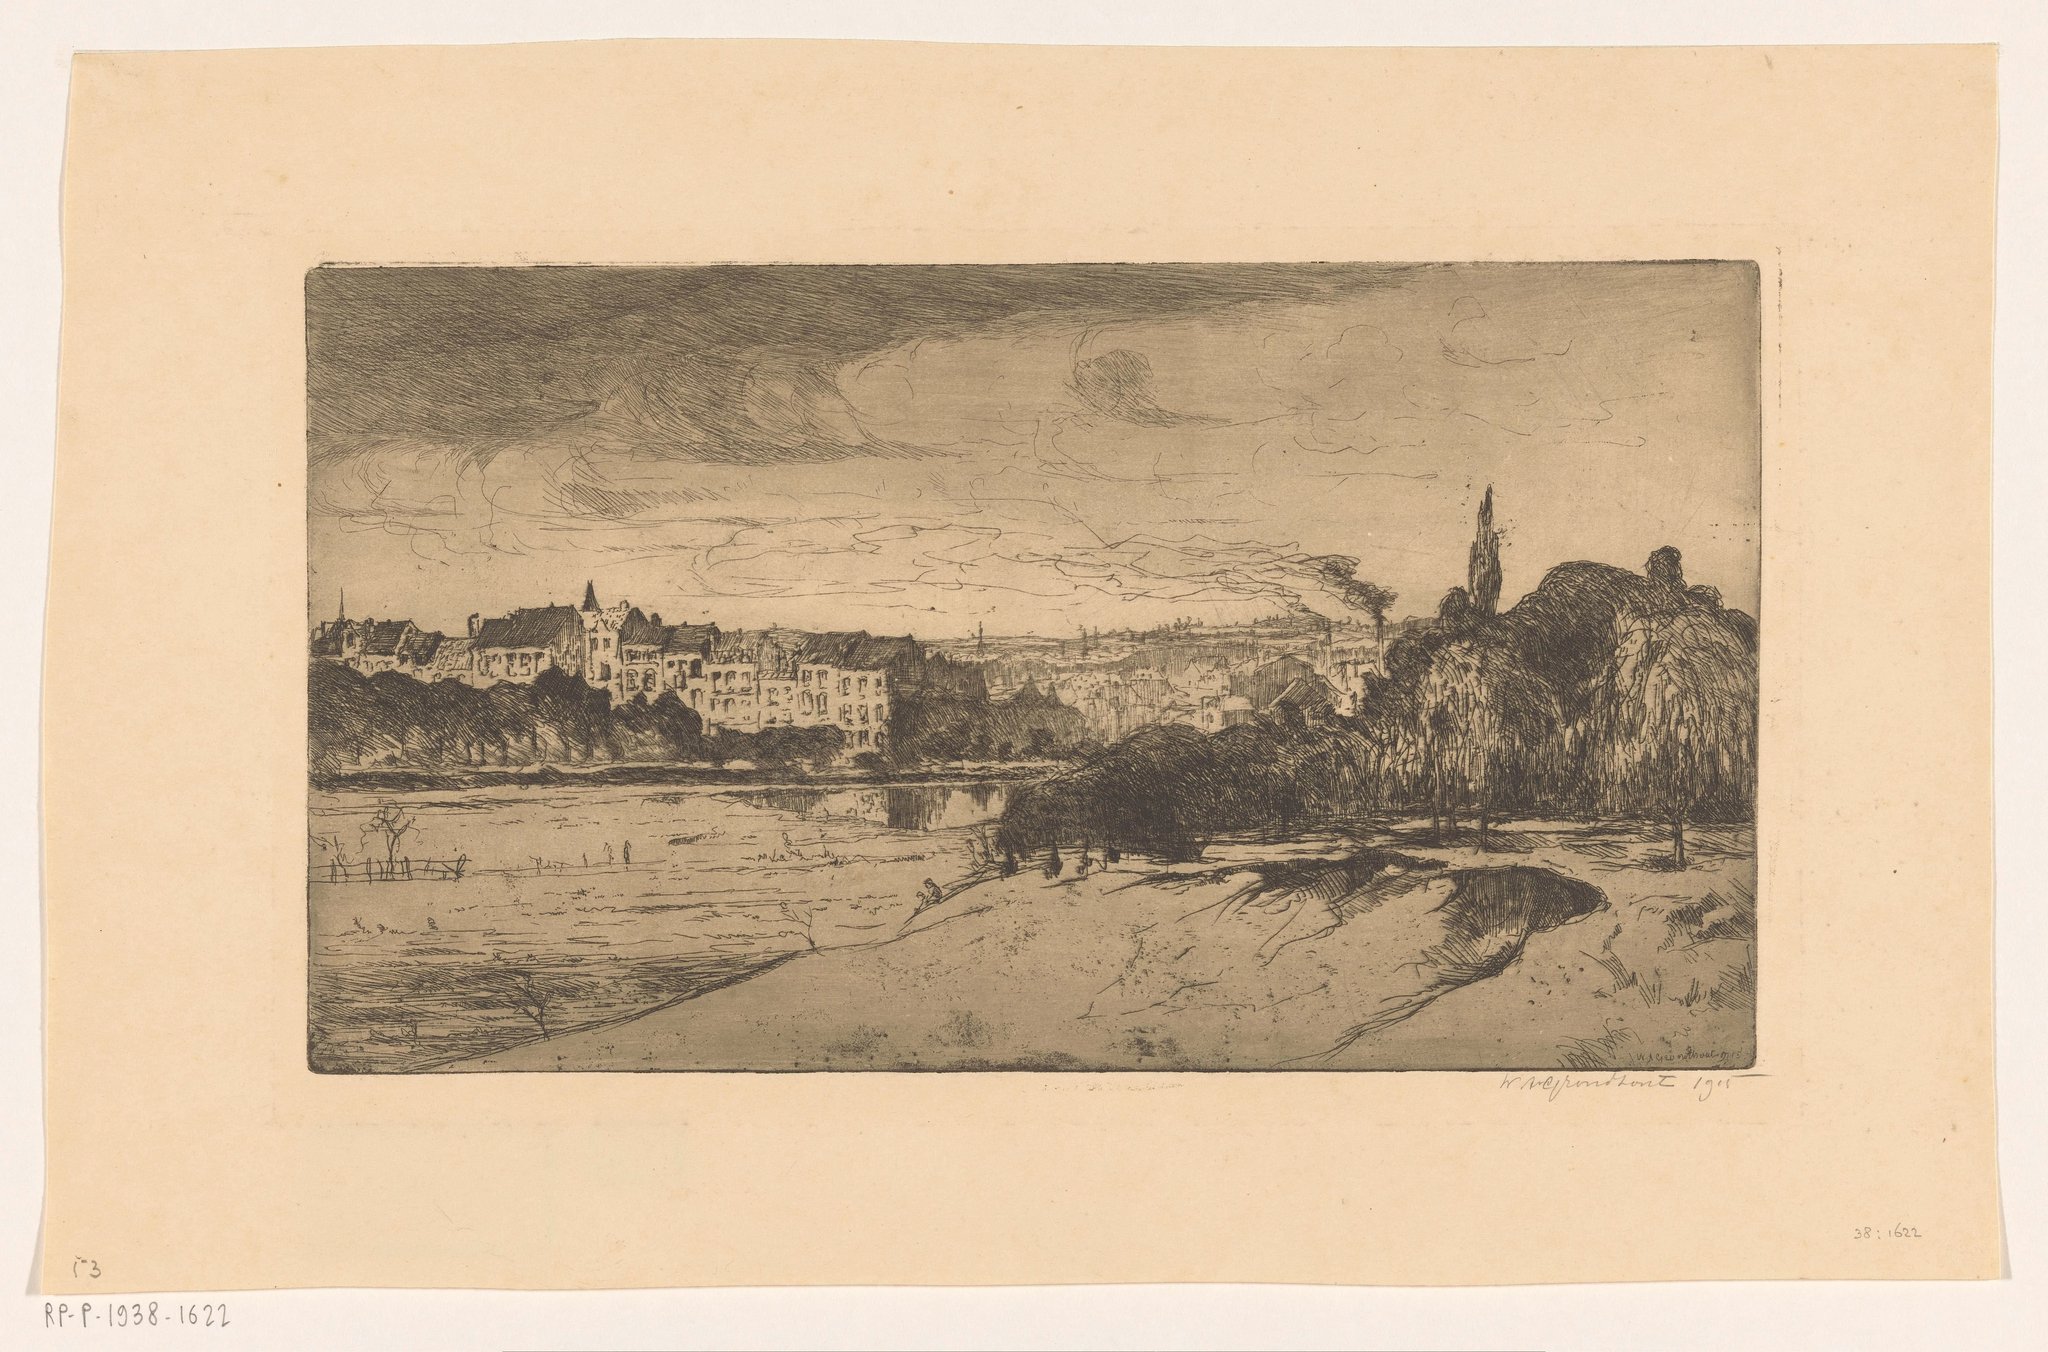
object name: print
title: Brussel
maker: willem adrianus grondhout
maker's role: draughtsman, painter, print maker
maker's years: 1878-1934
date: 1915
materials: paper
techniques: etching, intaglio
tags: city-view, and landscape with man-made constructions, river, brussels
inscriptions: collector's mark: Lugt 2228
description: Op de voorgrond een rivier. Op de achtergrond een stad.